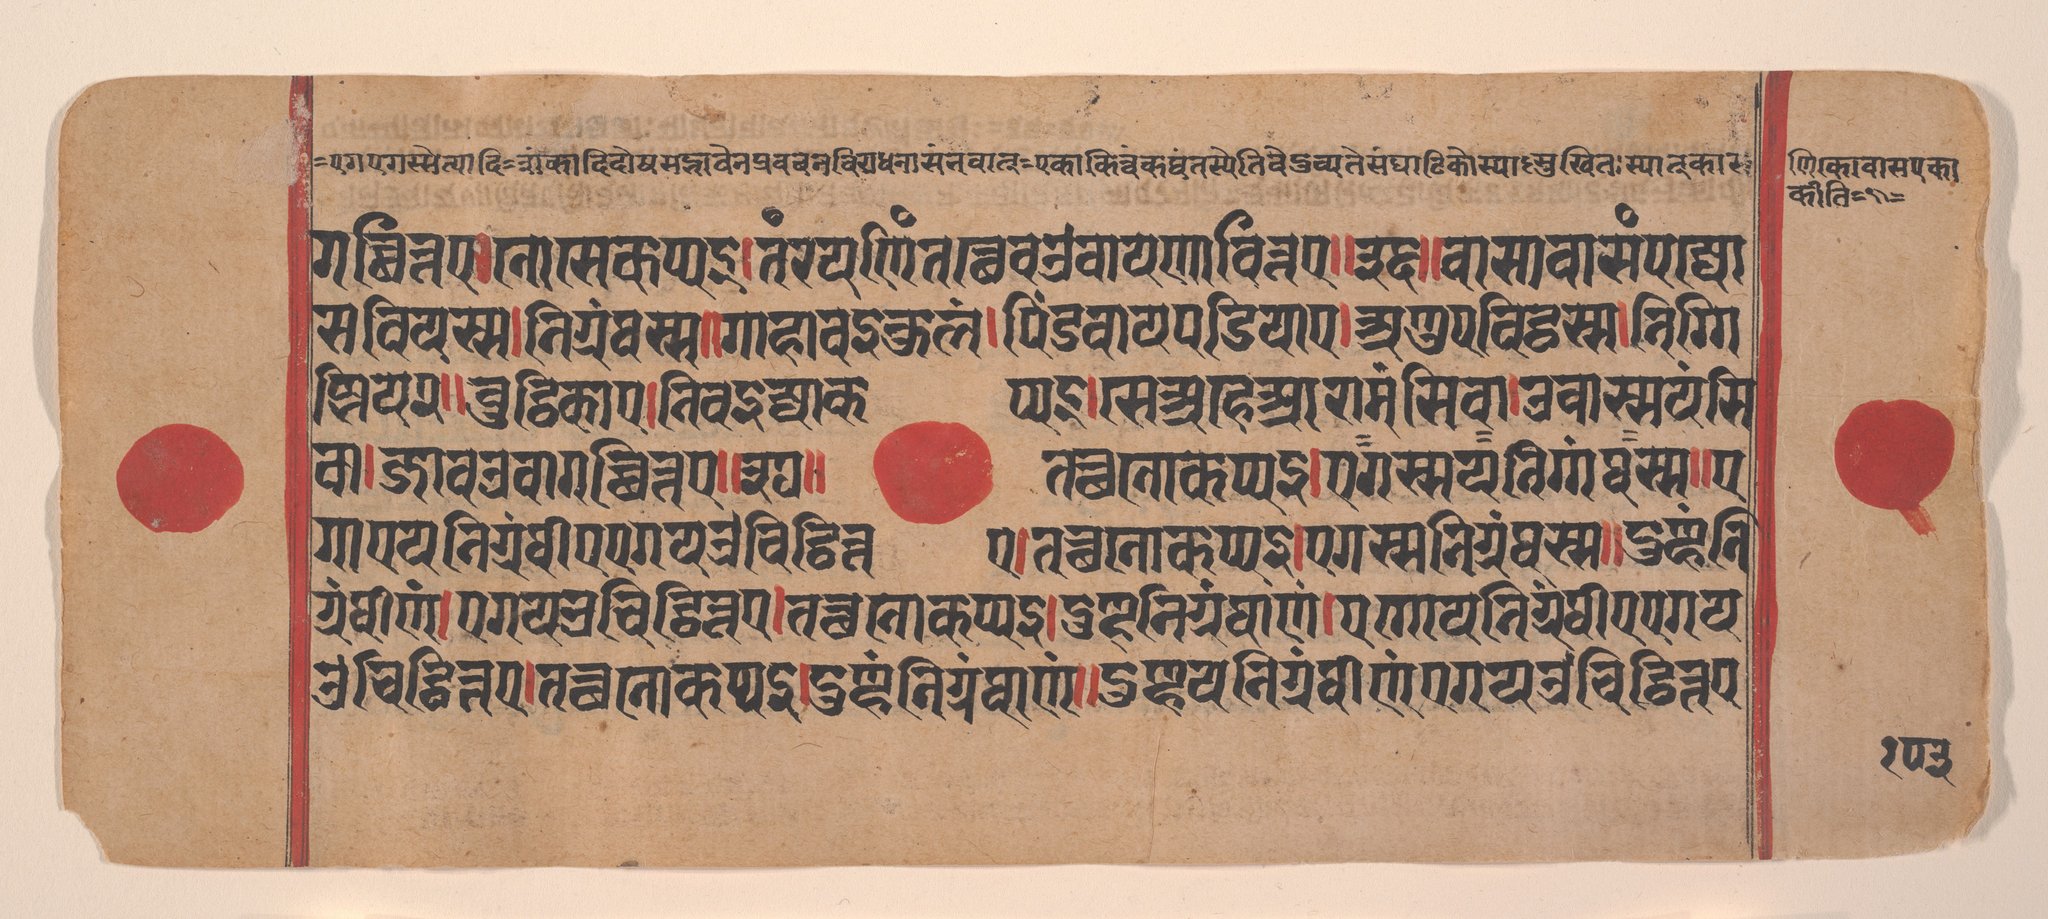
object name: folio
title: Page from a Dispersed Kalpa Sutra (Jain Book of Rituals)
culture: indian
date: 1401-1500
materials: gold, ink, paper, watercolor